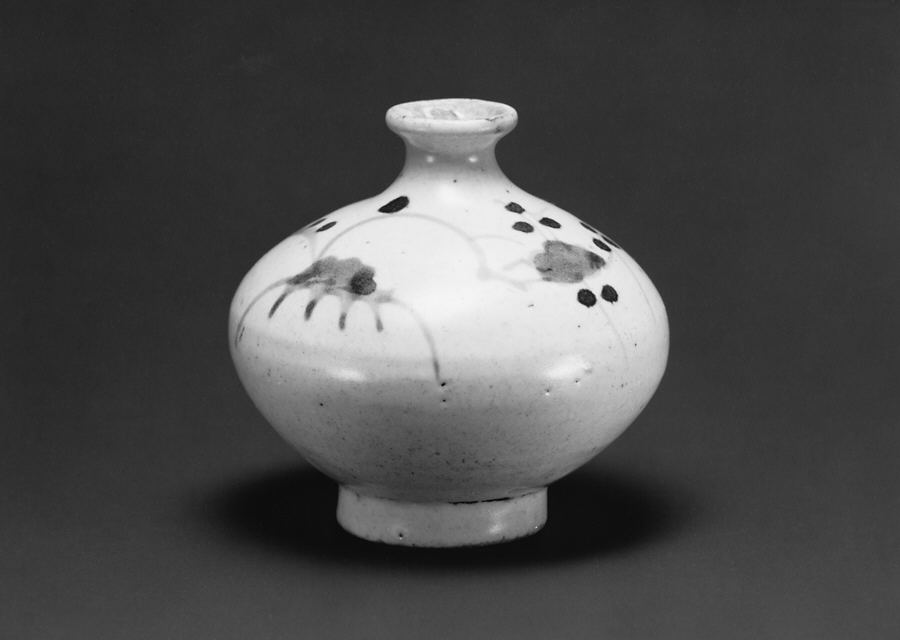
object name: bottle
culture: japanese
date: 1601-1800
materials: porcelain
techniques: underglaze